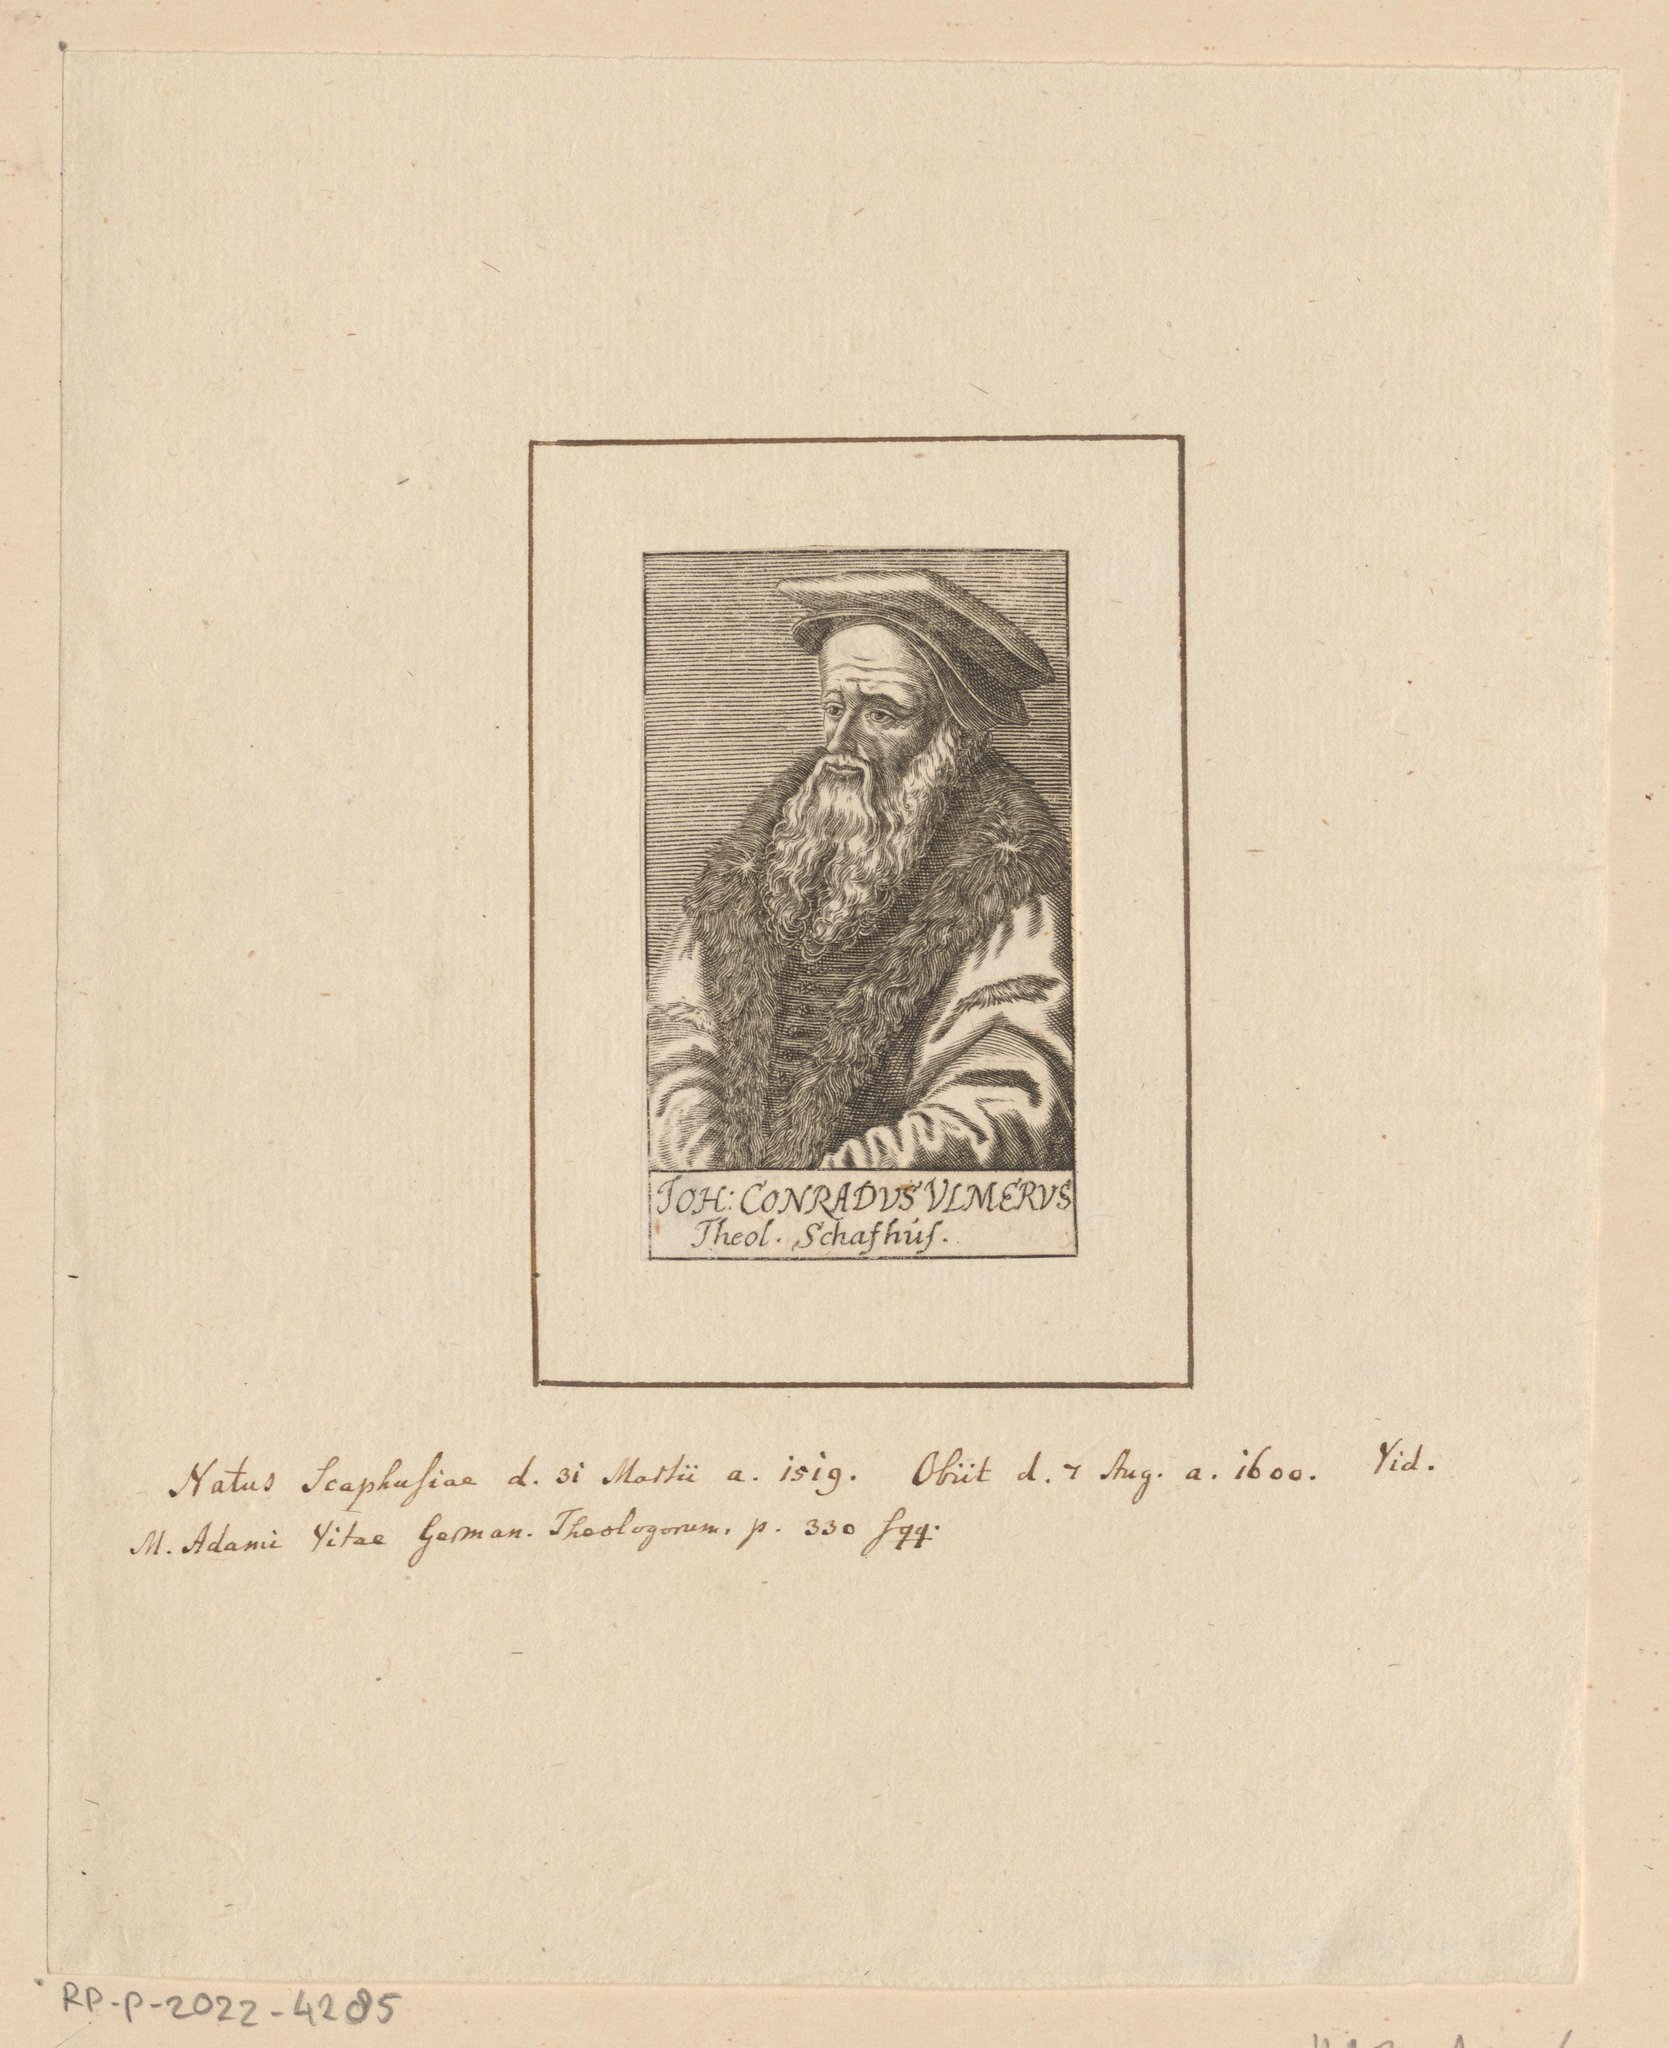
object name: book illustration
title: Portret van Johann Conrad Ulmer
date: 1688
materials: paper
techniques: engraving, etching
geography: nuremberg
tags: theologian, historical persons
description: Prent uit: Freher, Paul. Theatrum virorum eruditione clarorum. Neurenberg: Johann Hoffmann, 1688.